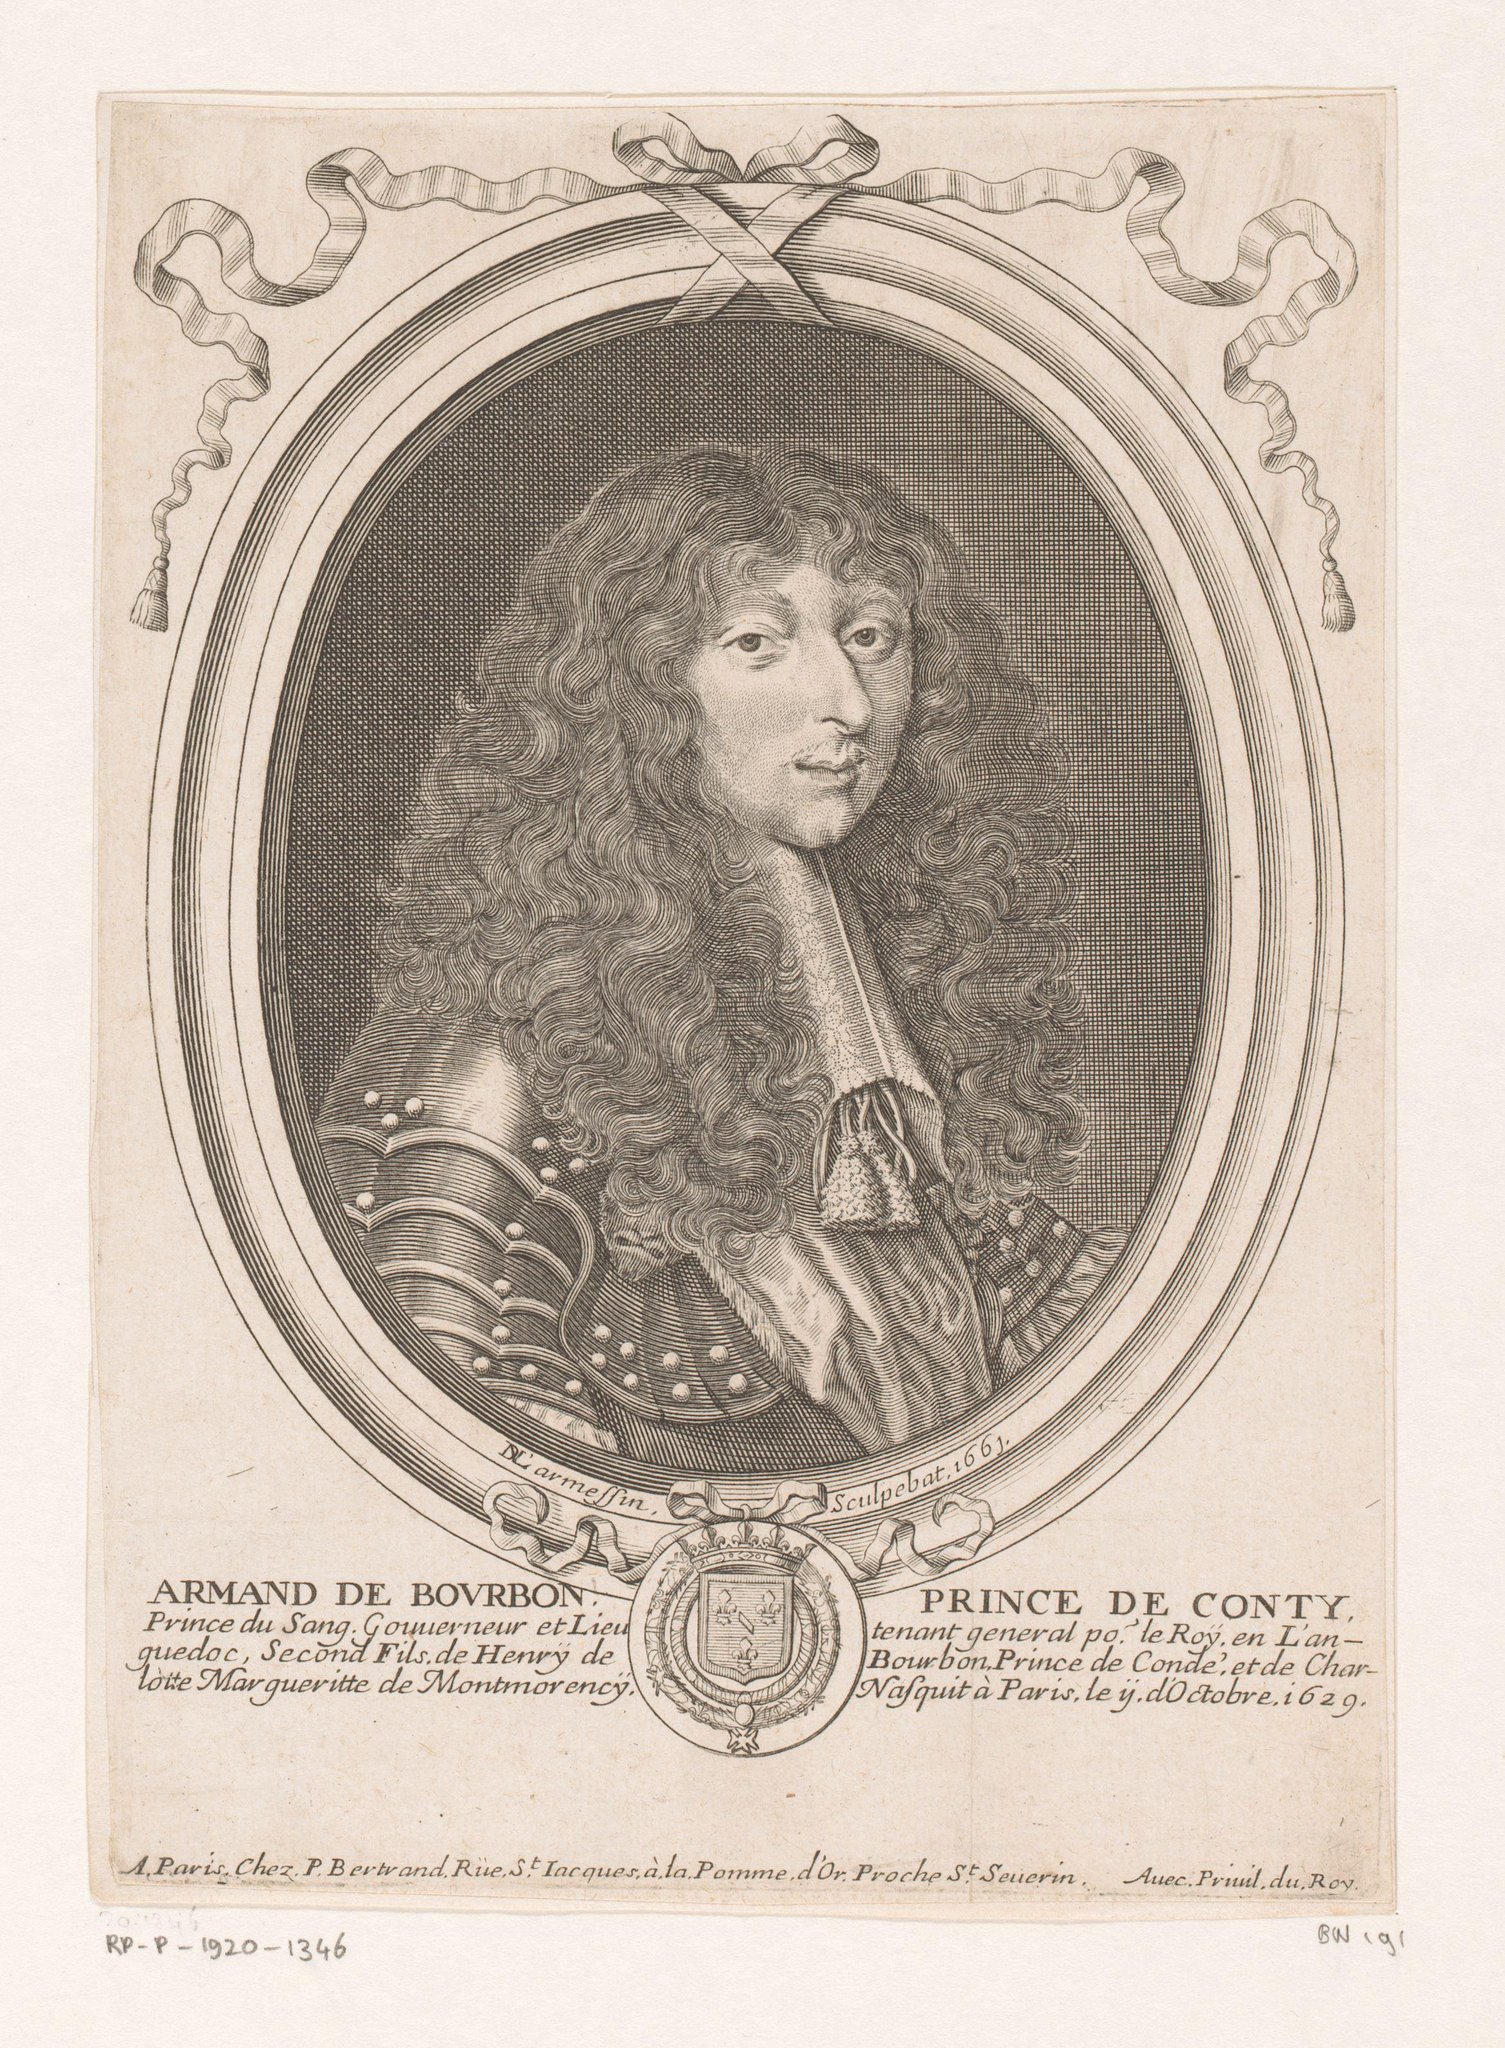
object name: print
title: Portret van Armand de Bourbon-Condé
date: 1661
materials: paper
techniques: engraving, etching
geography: france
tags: paris, historical persons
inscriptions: collector's mark: Lugt 2228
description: Maakt deel uit van een grootschalige serie met portretten van prominente figuren. Binnen de serie bevindt zich een sectie getiteld 'Les Augustes Représentations De tous les Roys De France depuis Pharamond Iusqu'à Louys XIIII'. De serie werd respectievelijk uitgegeven door Pierre Bertrand, door zijn weduwe en door De Larmessin zelf.